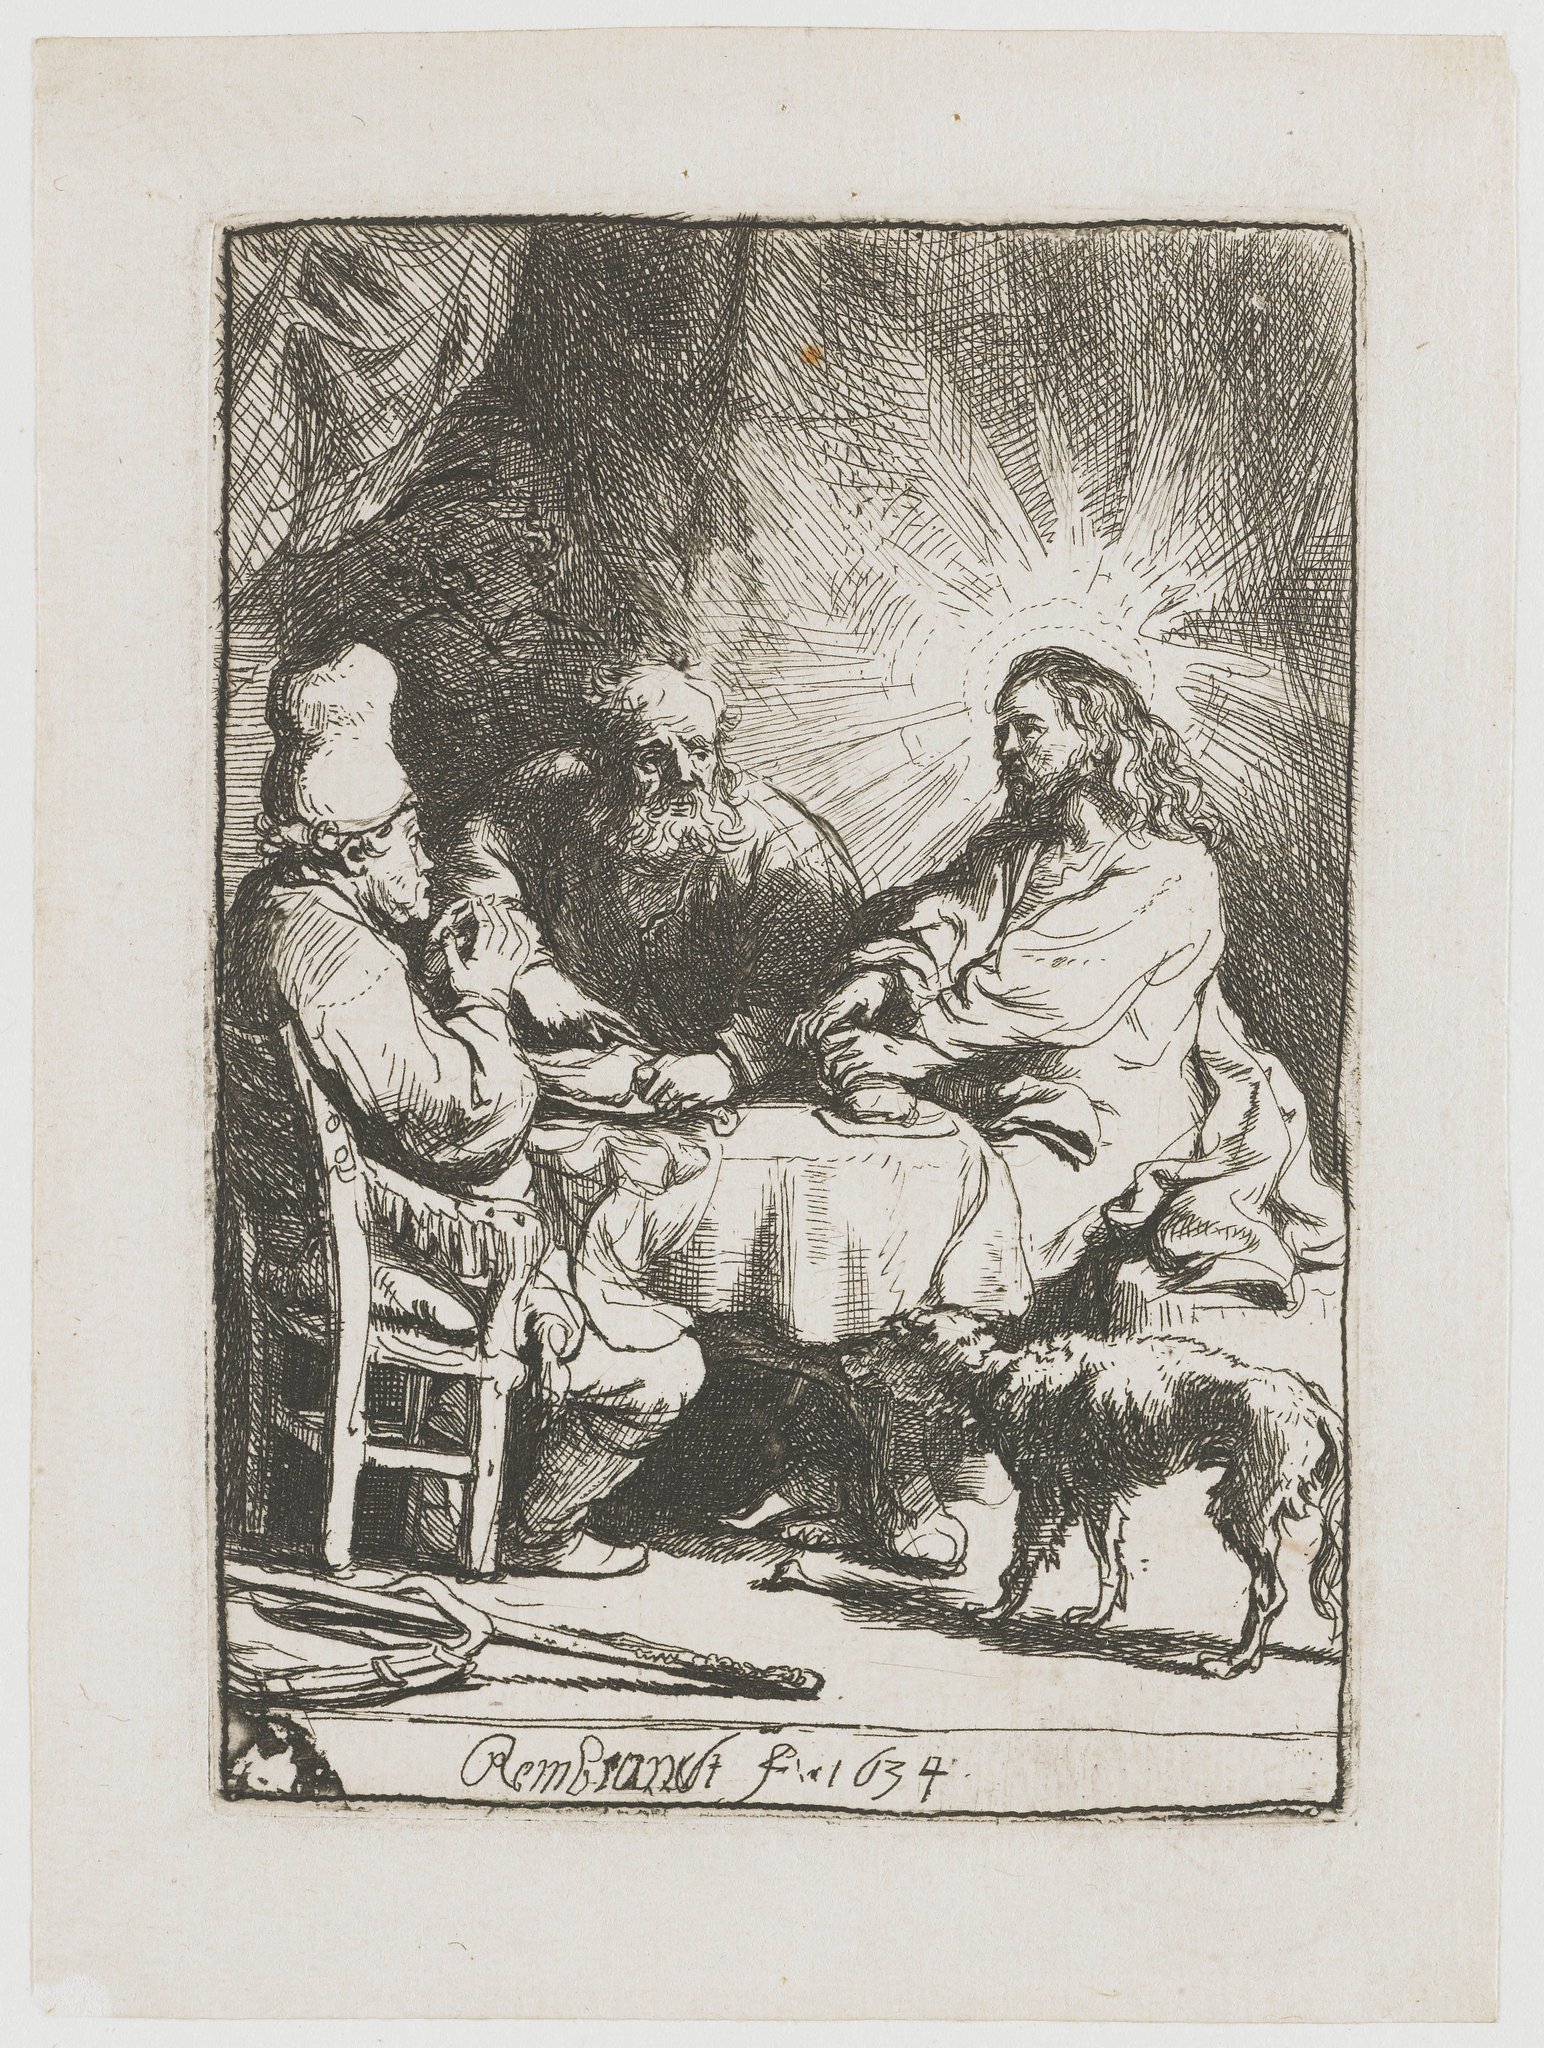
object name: print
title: The Supper at Emmaus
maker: rembrandt van rijn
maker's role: draughtsman, painter, print maker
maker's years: 1606-1669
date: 1634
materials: paper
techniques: drypoint, etching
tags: the supper at emmaus: christ is recognized while blessing or breaking the bread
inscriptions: inscription: ‘199’, signature and date: ‘Rembrandt f. 1634’, collector's mark: Lugt 240